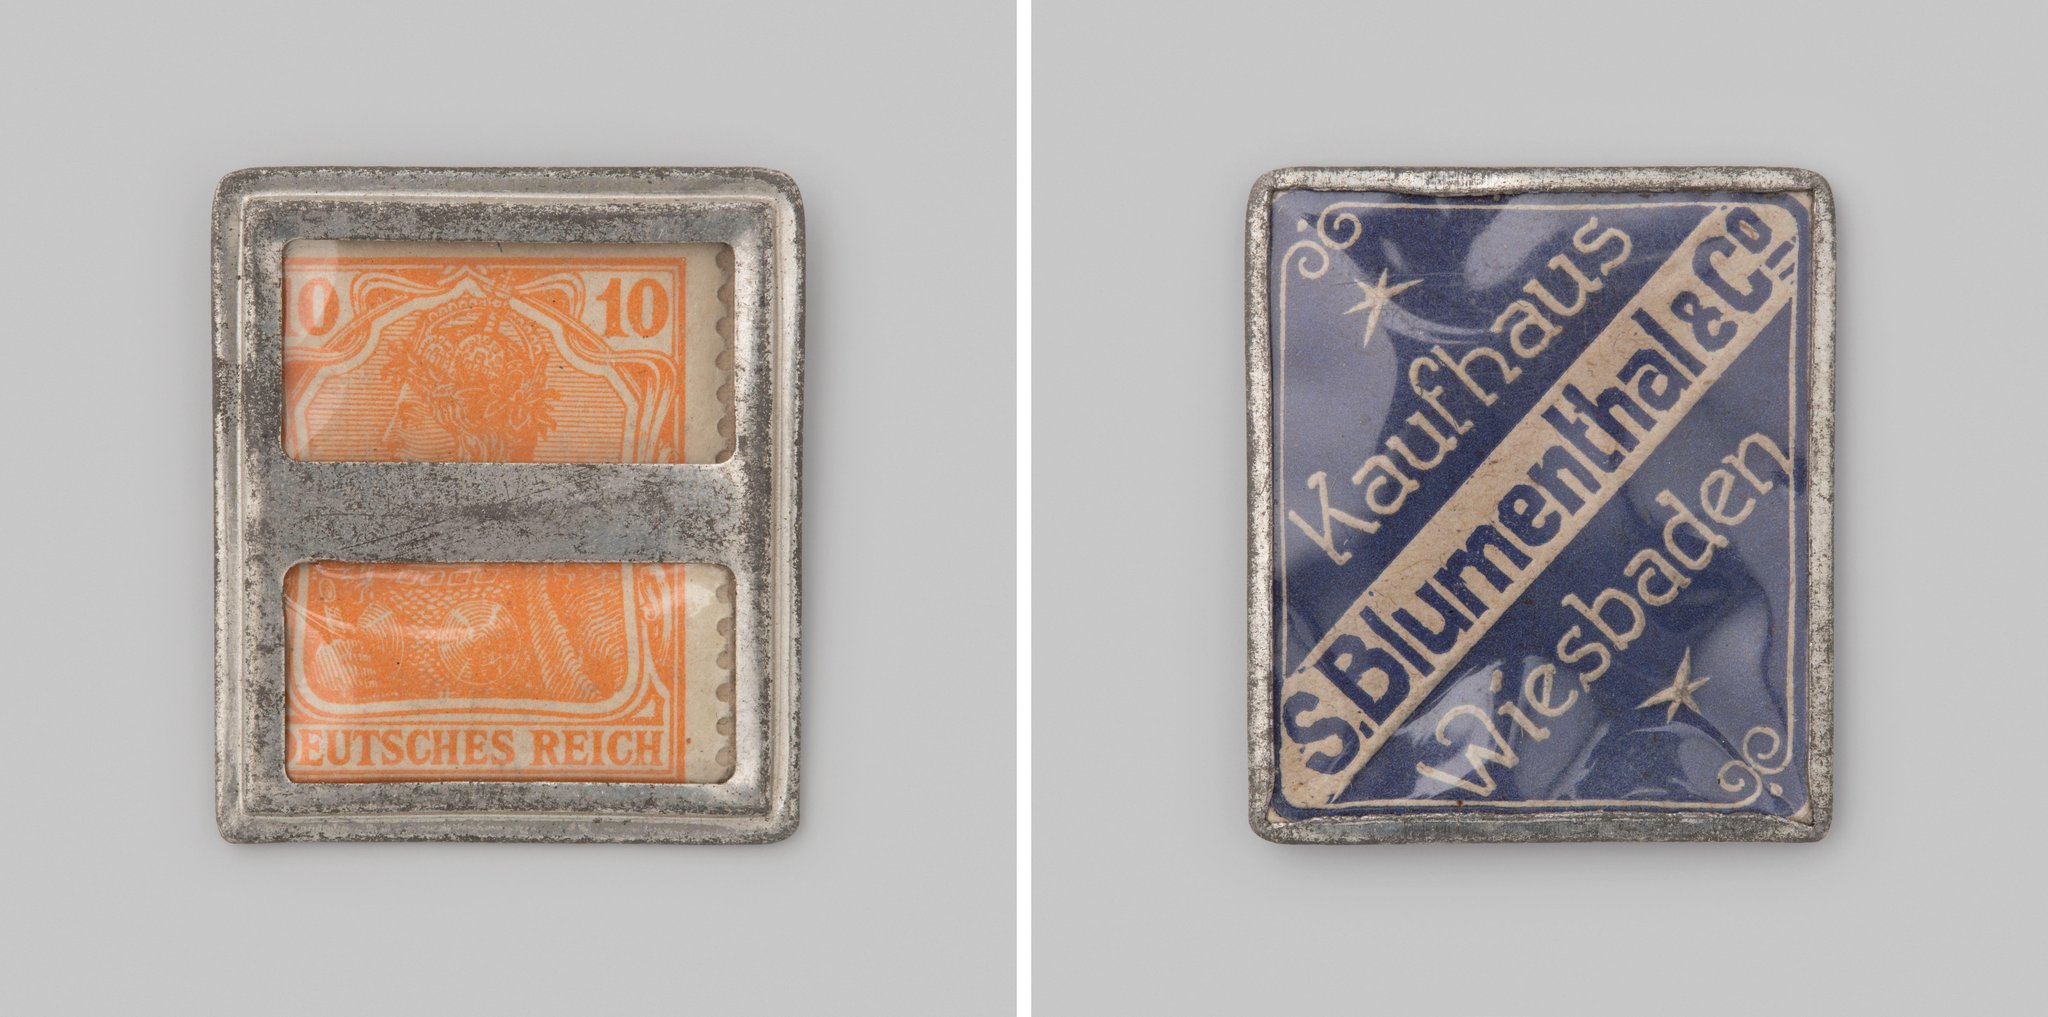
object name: tien pfennig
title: 10 pfennig uit Duitsland, Wiesbaden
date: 1921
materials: iron, paper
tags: amsterdam, alexander johannes jacobus philippus haas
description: Door particuliere firma als hulpmunt uitgegeven, in ijzeren raam gevatte postzegel. Voorzijde: oranjekleurige Duitse postzegel van 10 pfennig uit de Germania serie. Keerzijde: op blauwe ondergrond schuin geplaatste aanduiding van de firma en plaatsnaam.